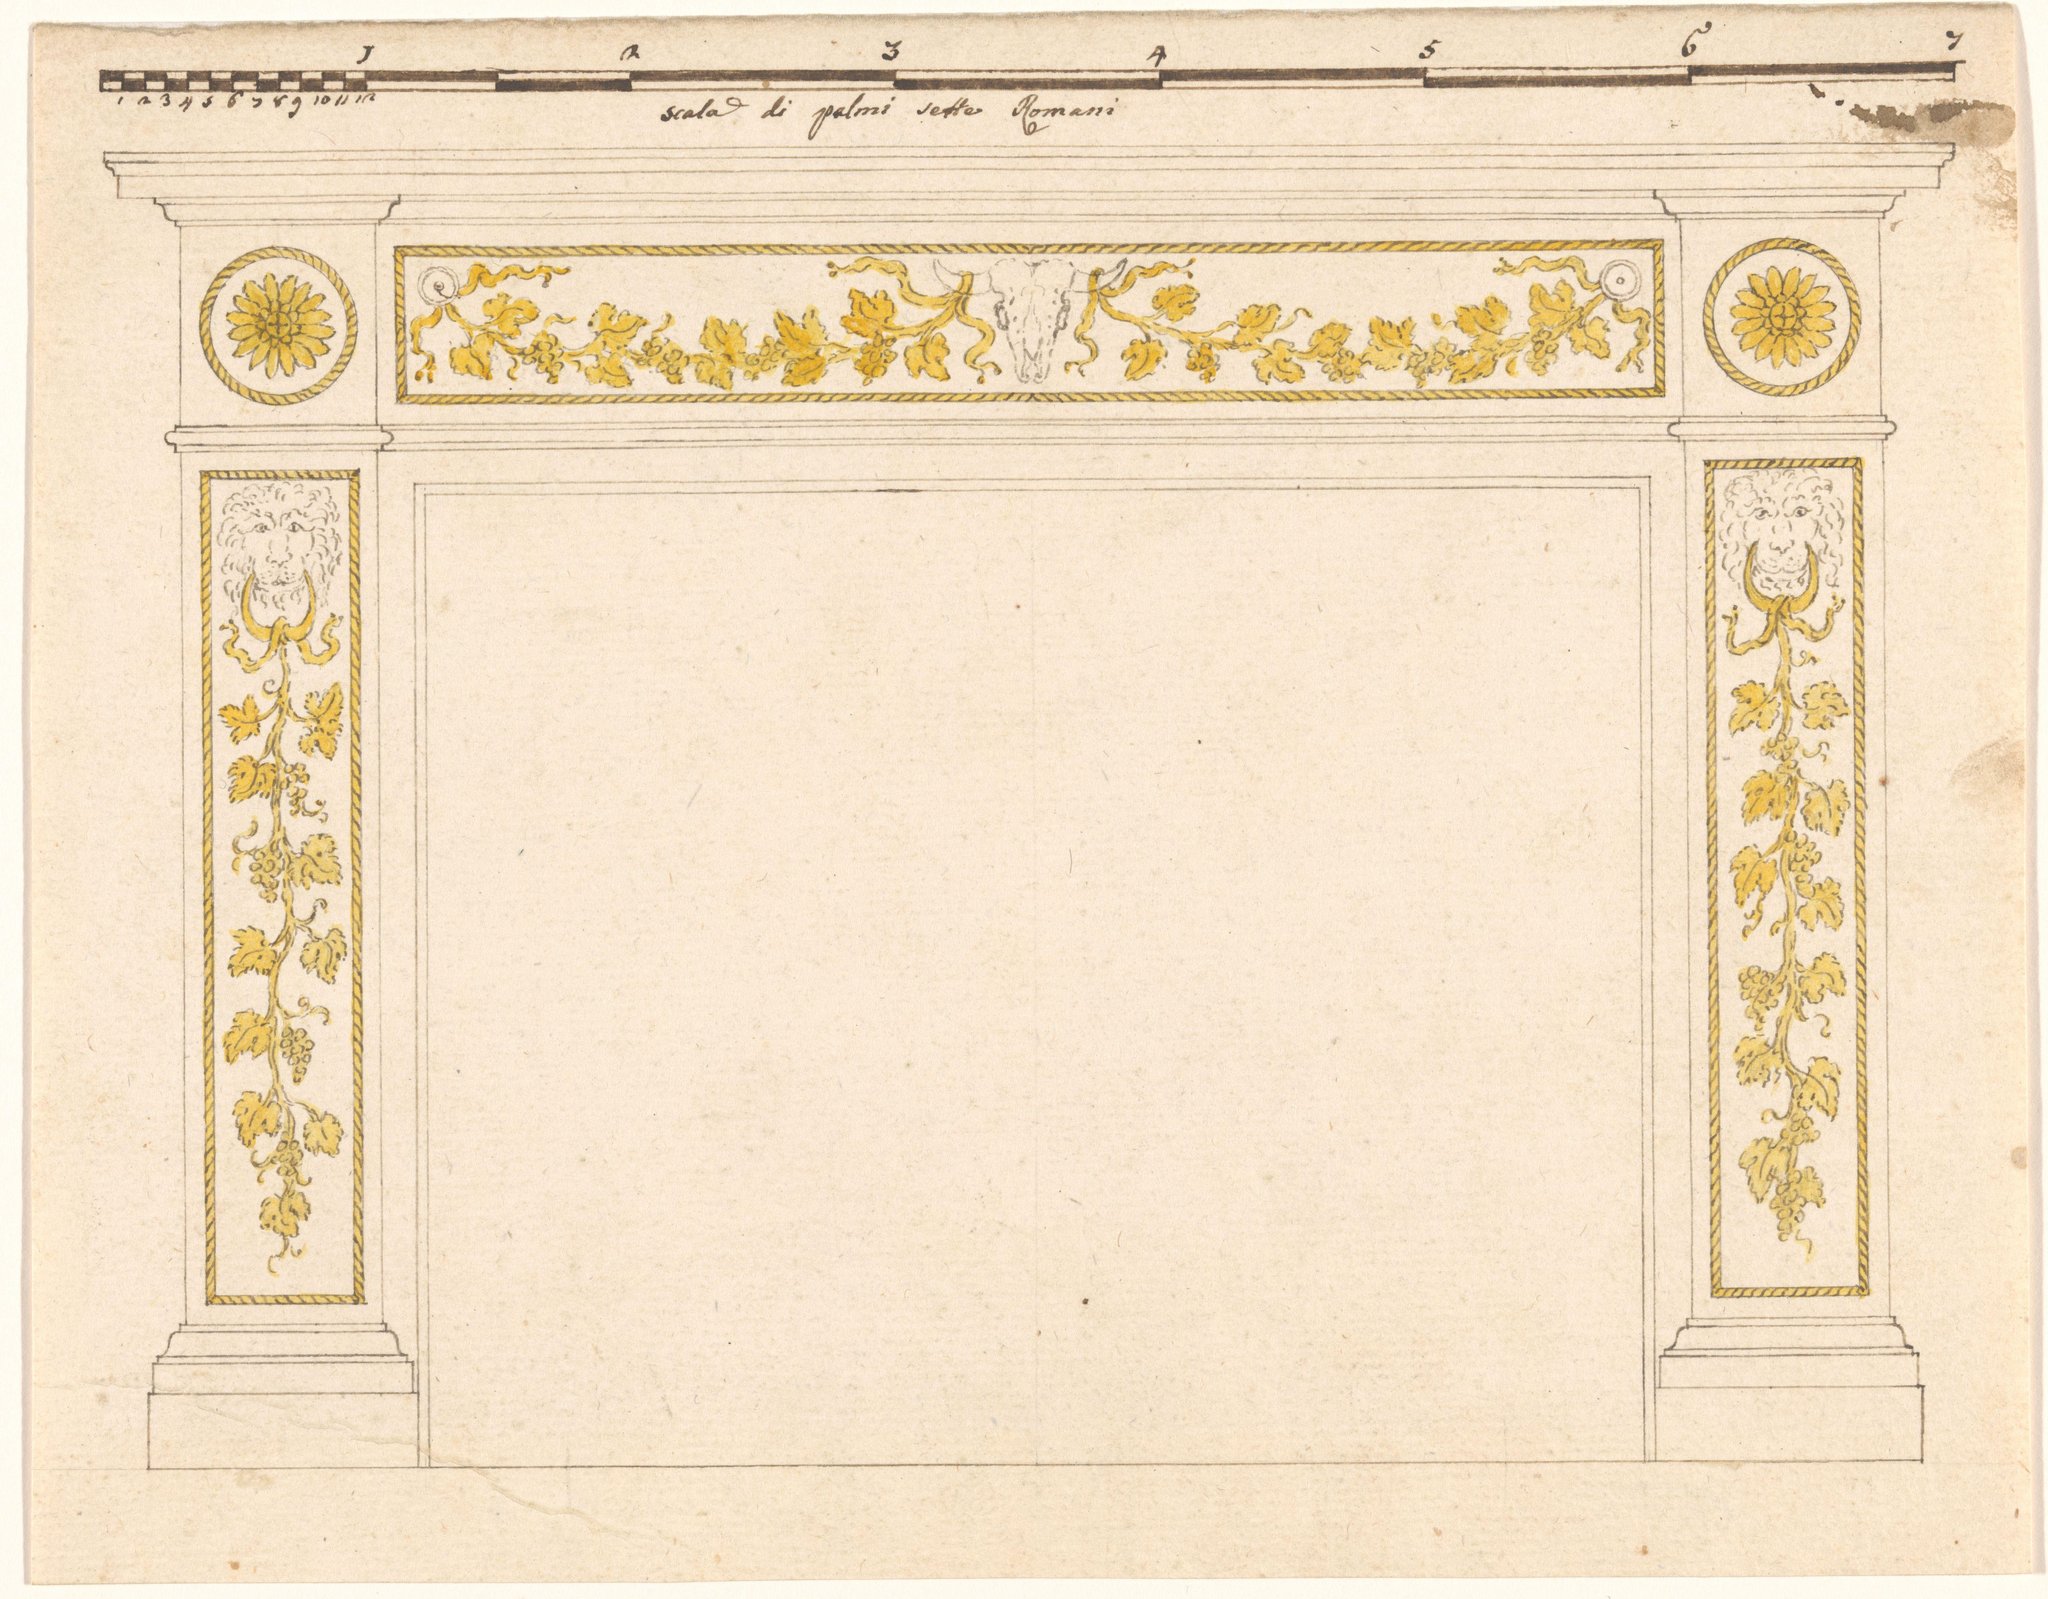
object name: drawing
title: Wit marmeren schoorsteenmantel met verguld bronzen versieringen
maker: Anonymous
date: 1765-1775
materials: ink, paper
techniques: brush, pen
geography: rome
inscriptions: watermark, inscription: ‘1 2 3 4 5 6 7 / 1 2 3 4 5 6 7 8 9 10 11 12 / scala di palmi sette Romani’